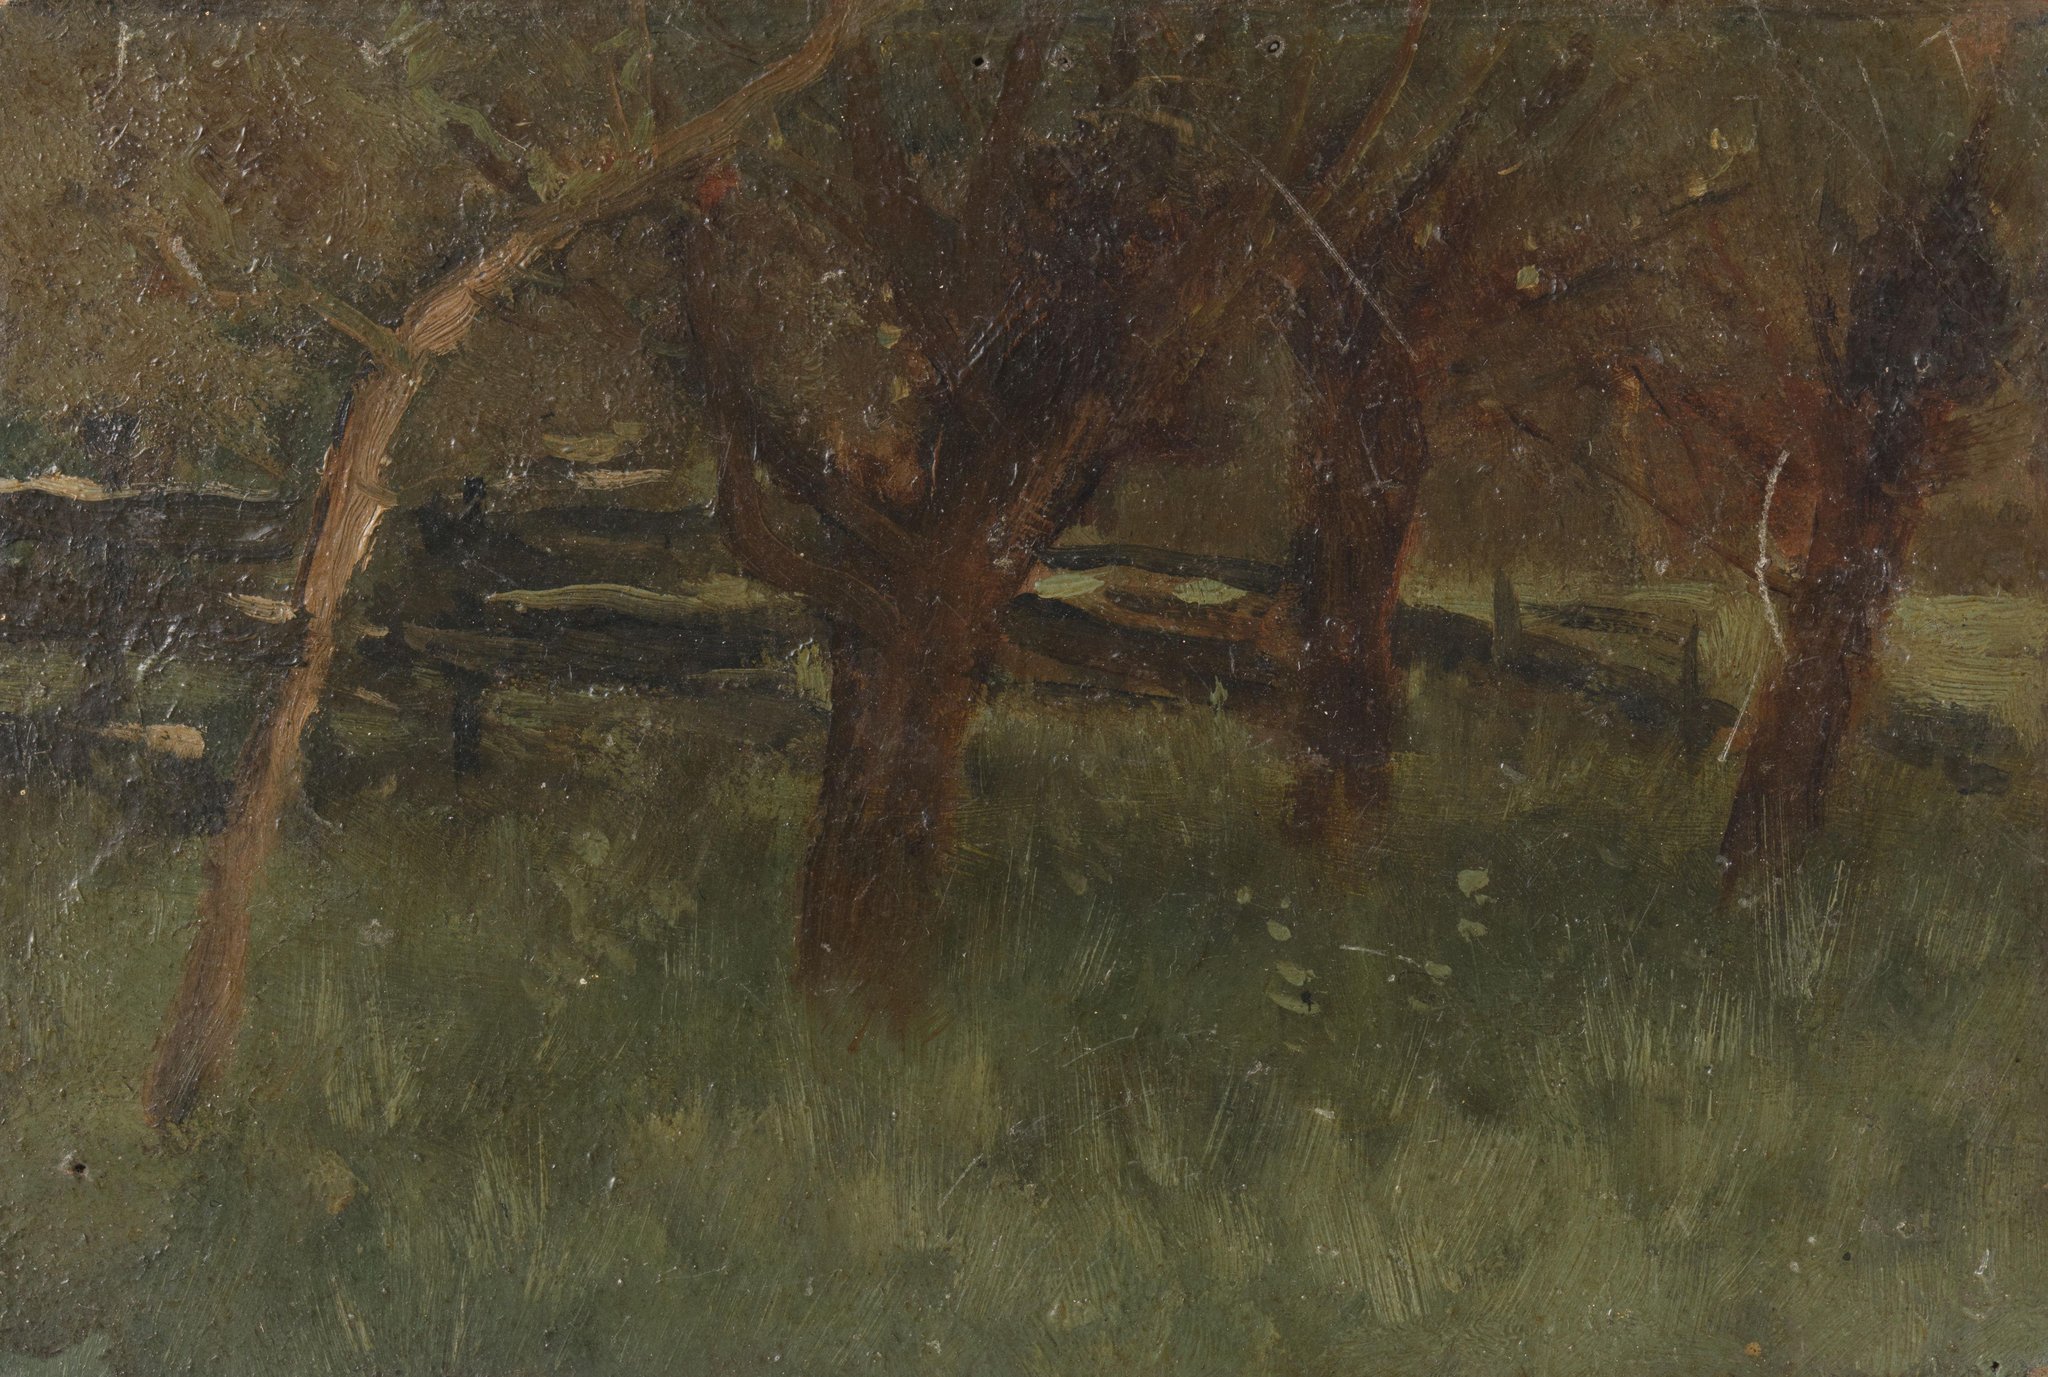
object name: painting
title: Boomgaard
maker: geo poggenbeek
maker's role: draughtsman, painter, print maker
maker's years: 1853-1903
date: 1873-1903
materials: cardboard, oil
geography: netherlands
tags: orchard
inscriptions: workshop stamp: ‘Geo Poggenbeek’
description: Boomgaard. Een weide met enkele bomen, aan de achterzijde afgesloten door een hek.